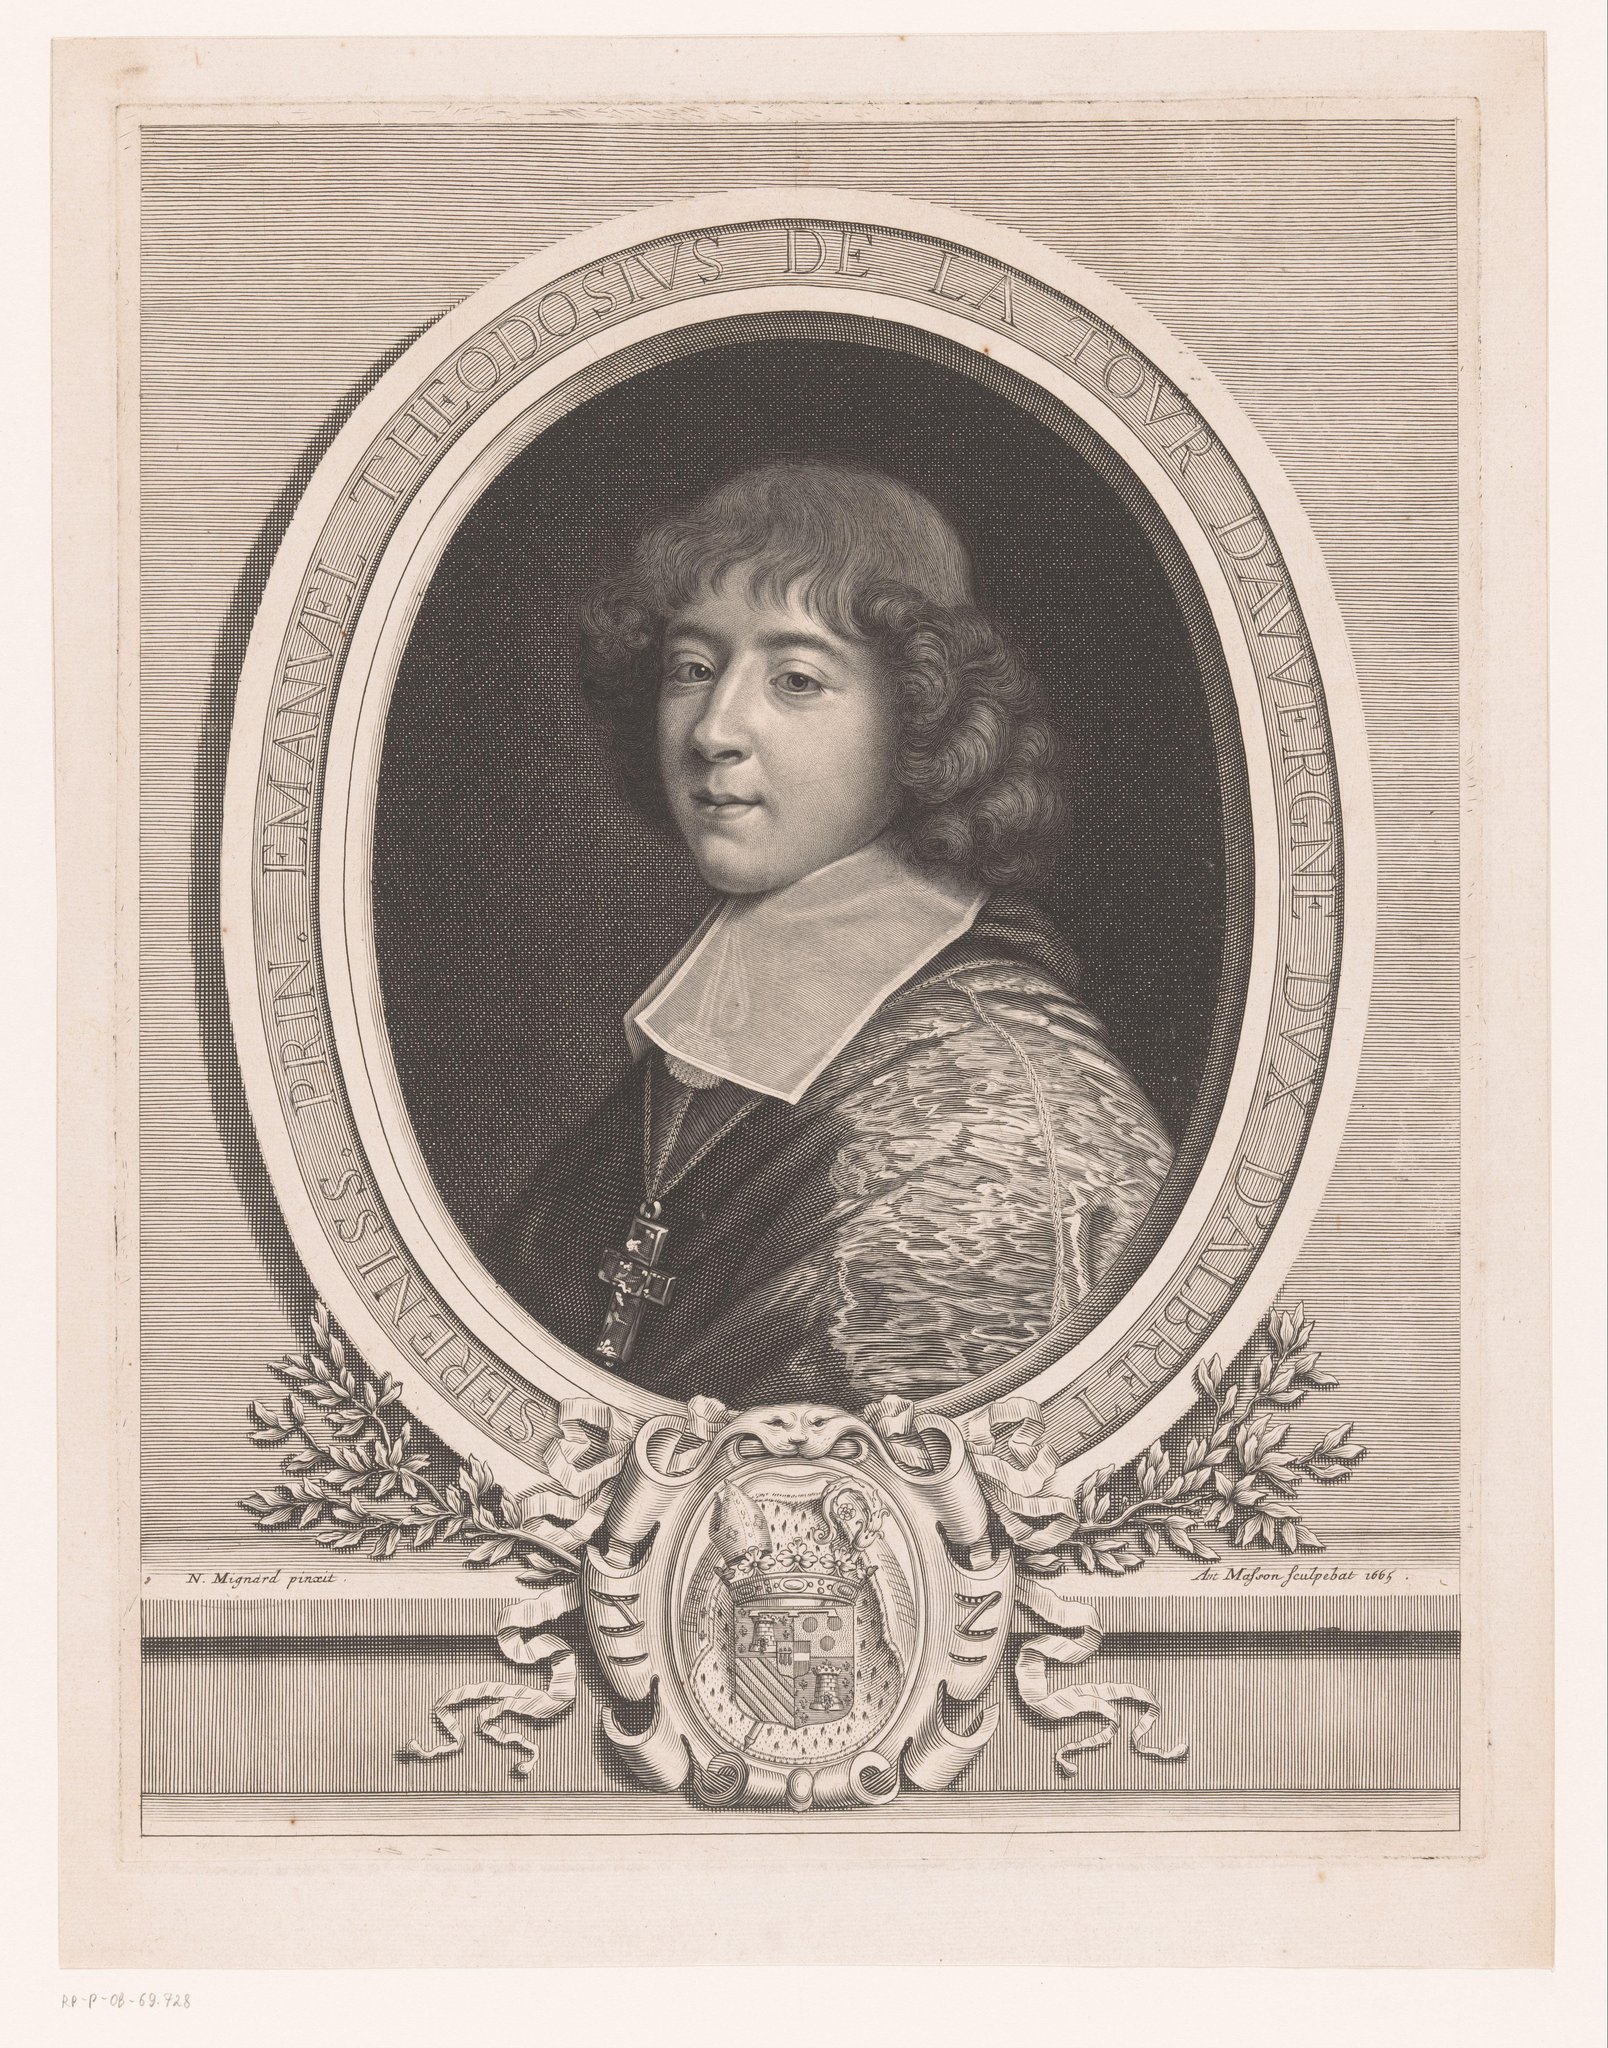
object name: print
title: Portret van Emmanuel Théodose de la Tour d'Auvergne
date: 1665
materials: paper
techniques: engraving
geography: france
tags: rome, cardinal, historical persons, armorial bearing, heraldry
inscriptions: collector's mark: Lugt 240